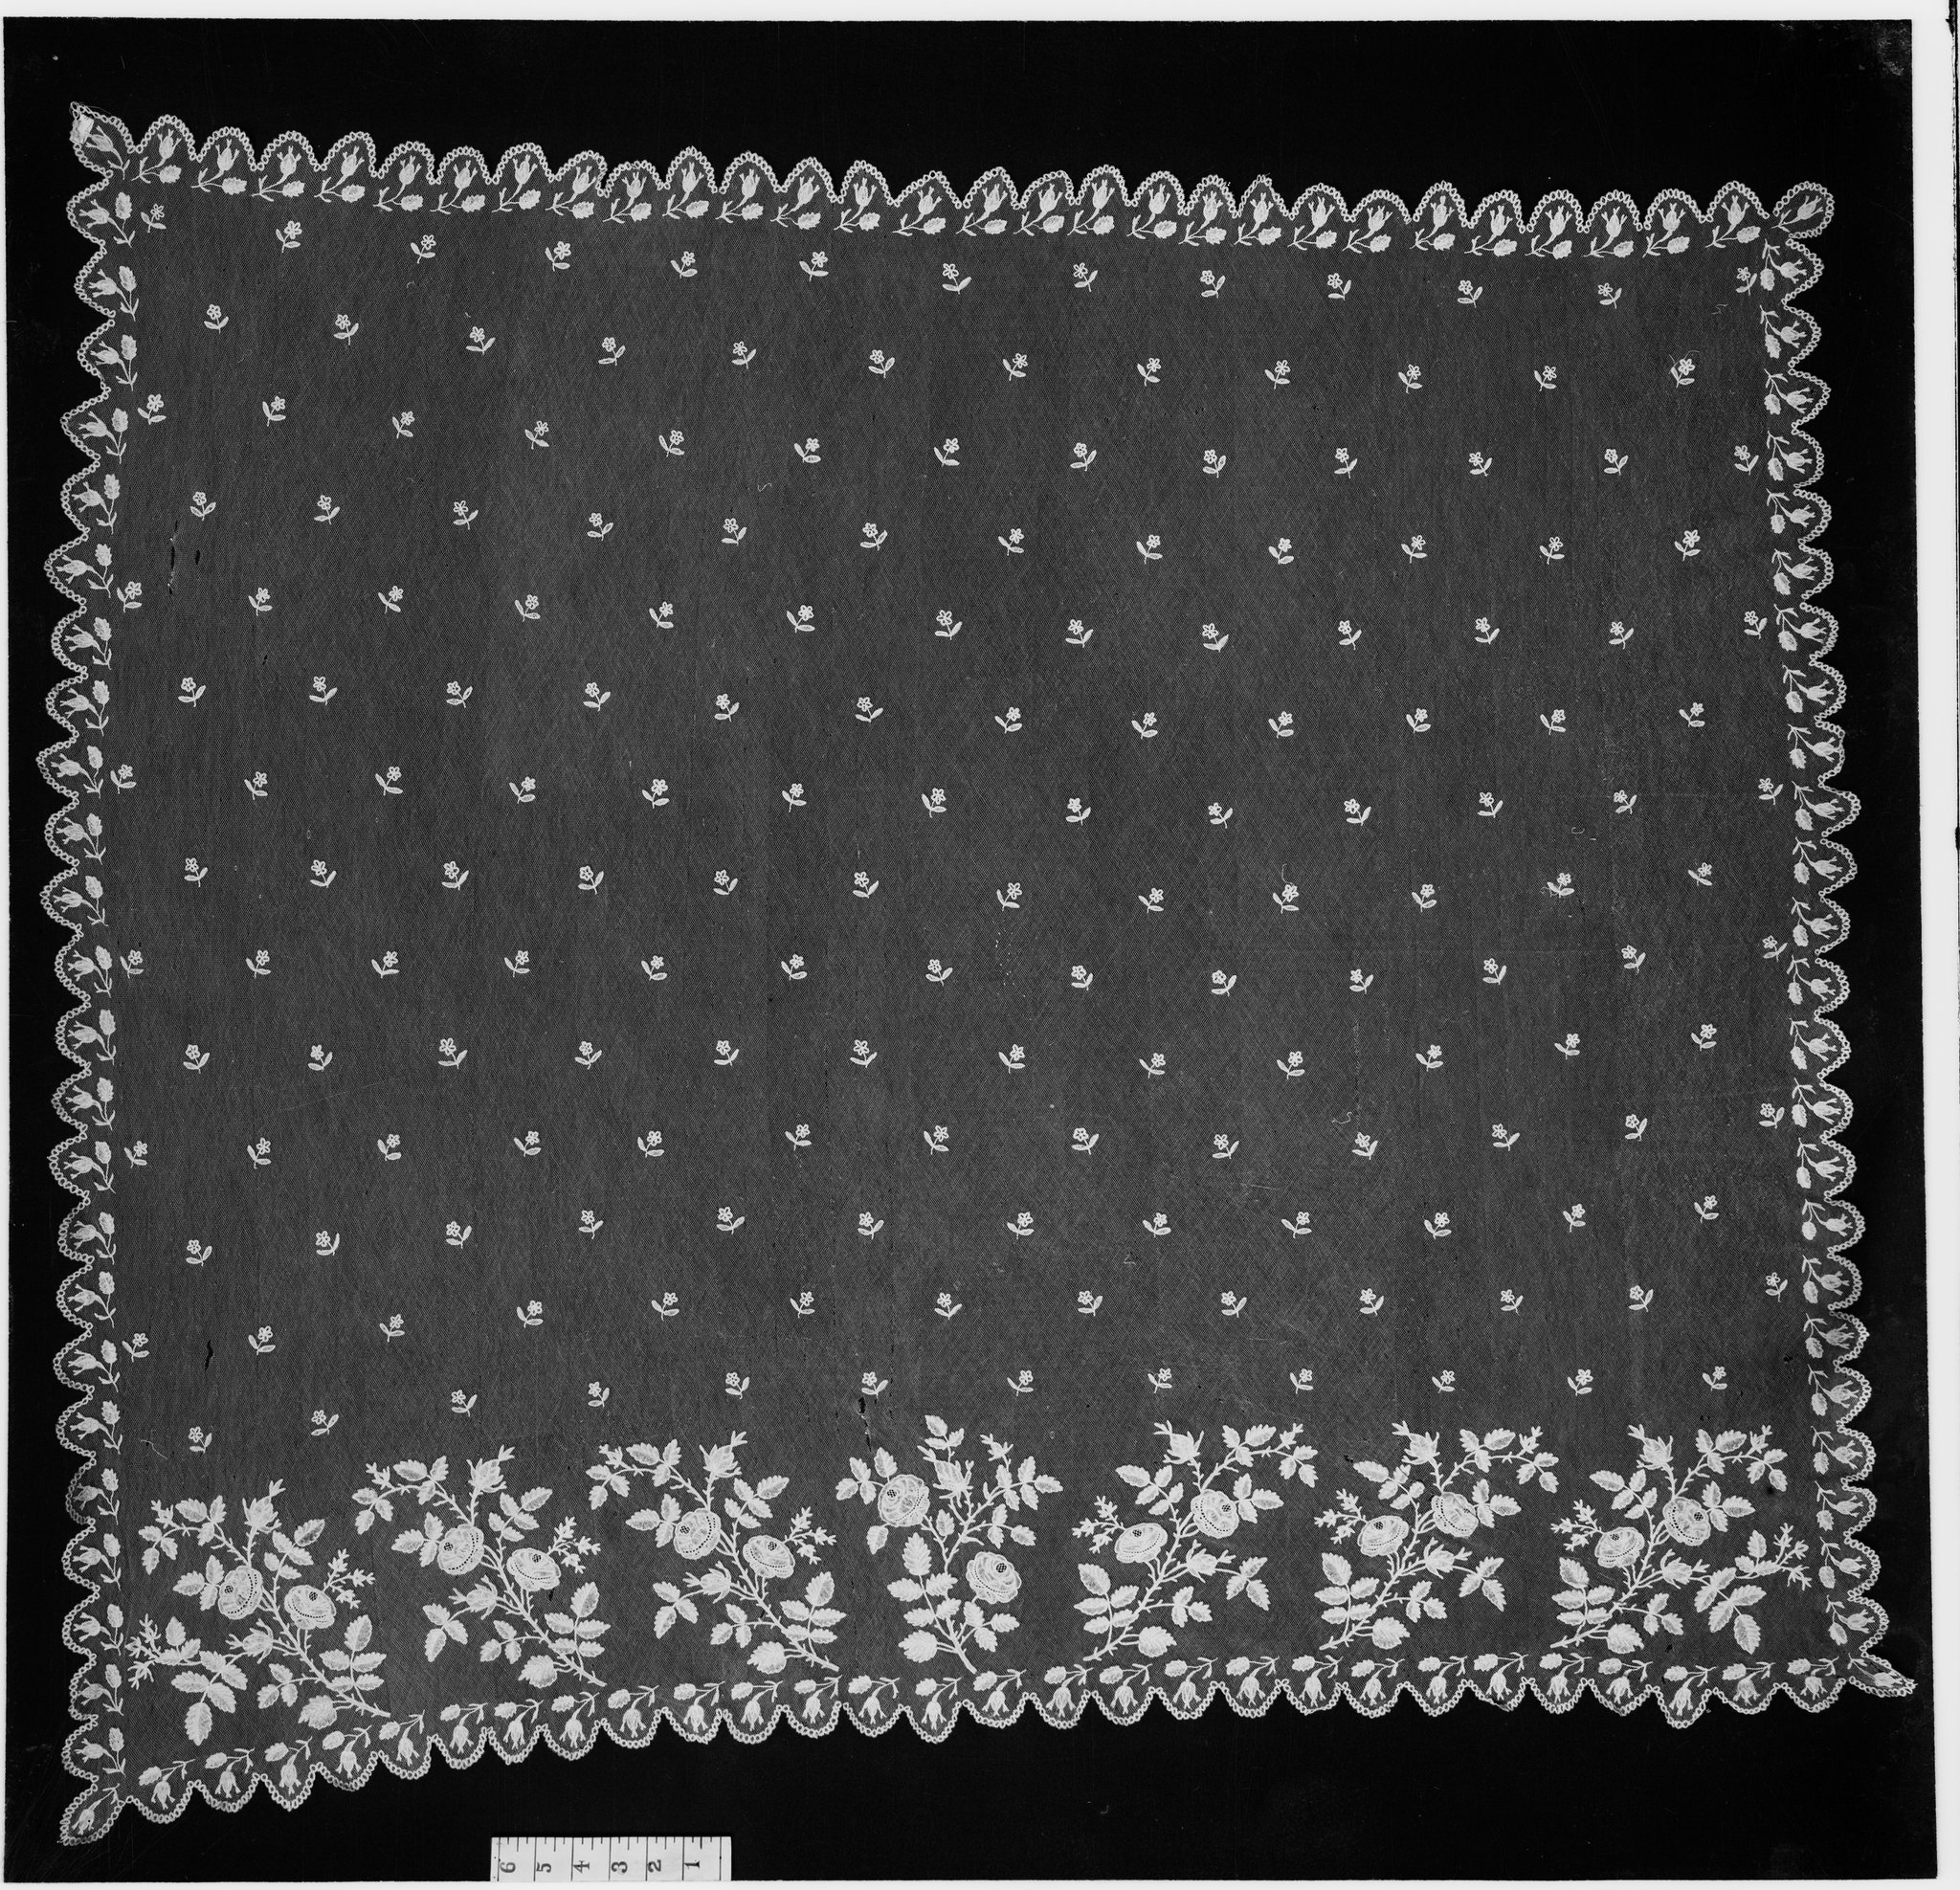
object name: veil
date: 1826-1850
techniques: lace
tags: flowers